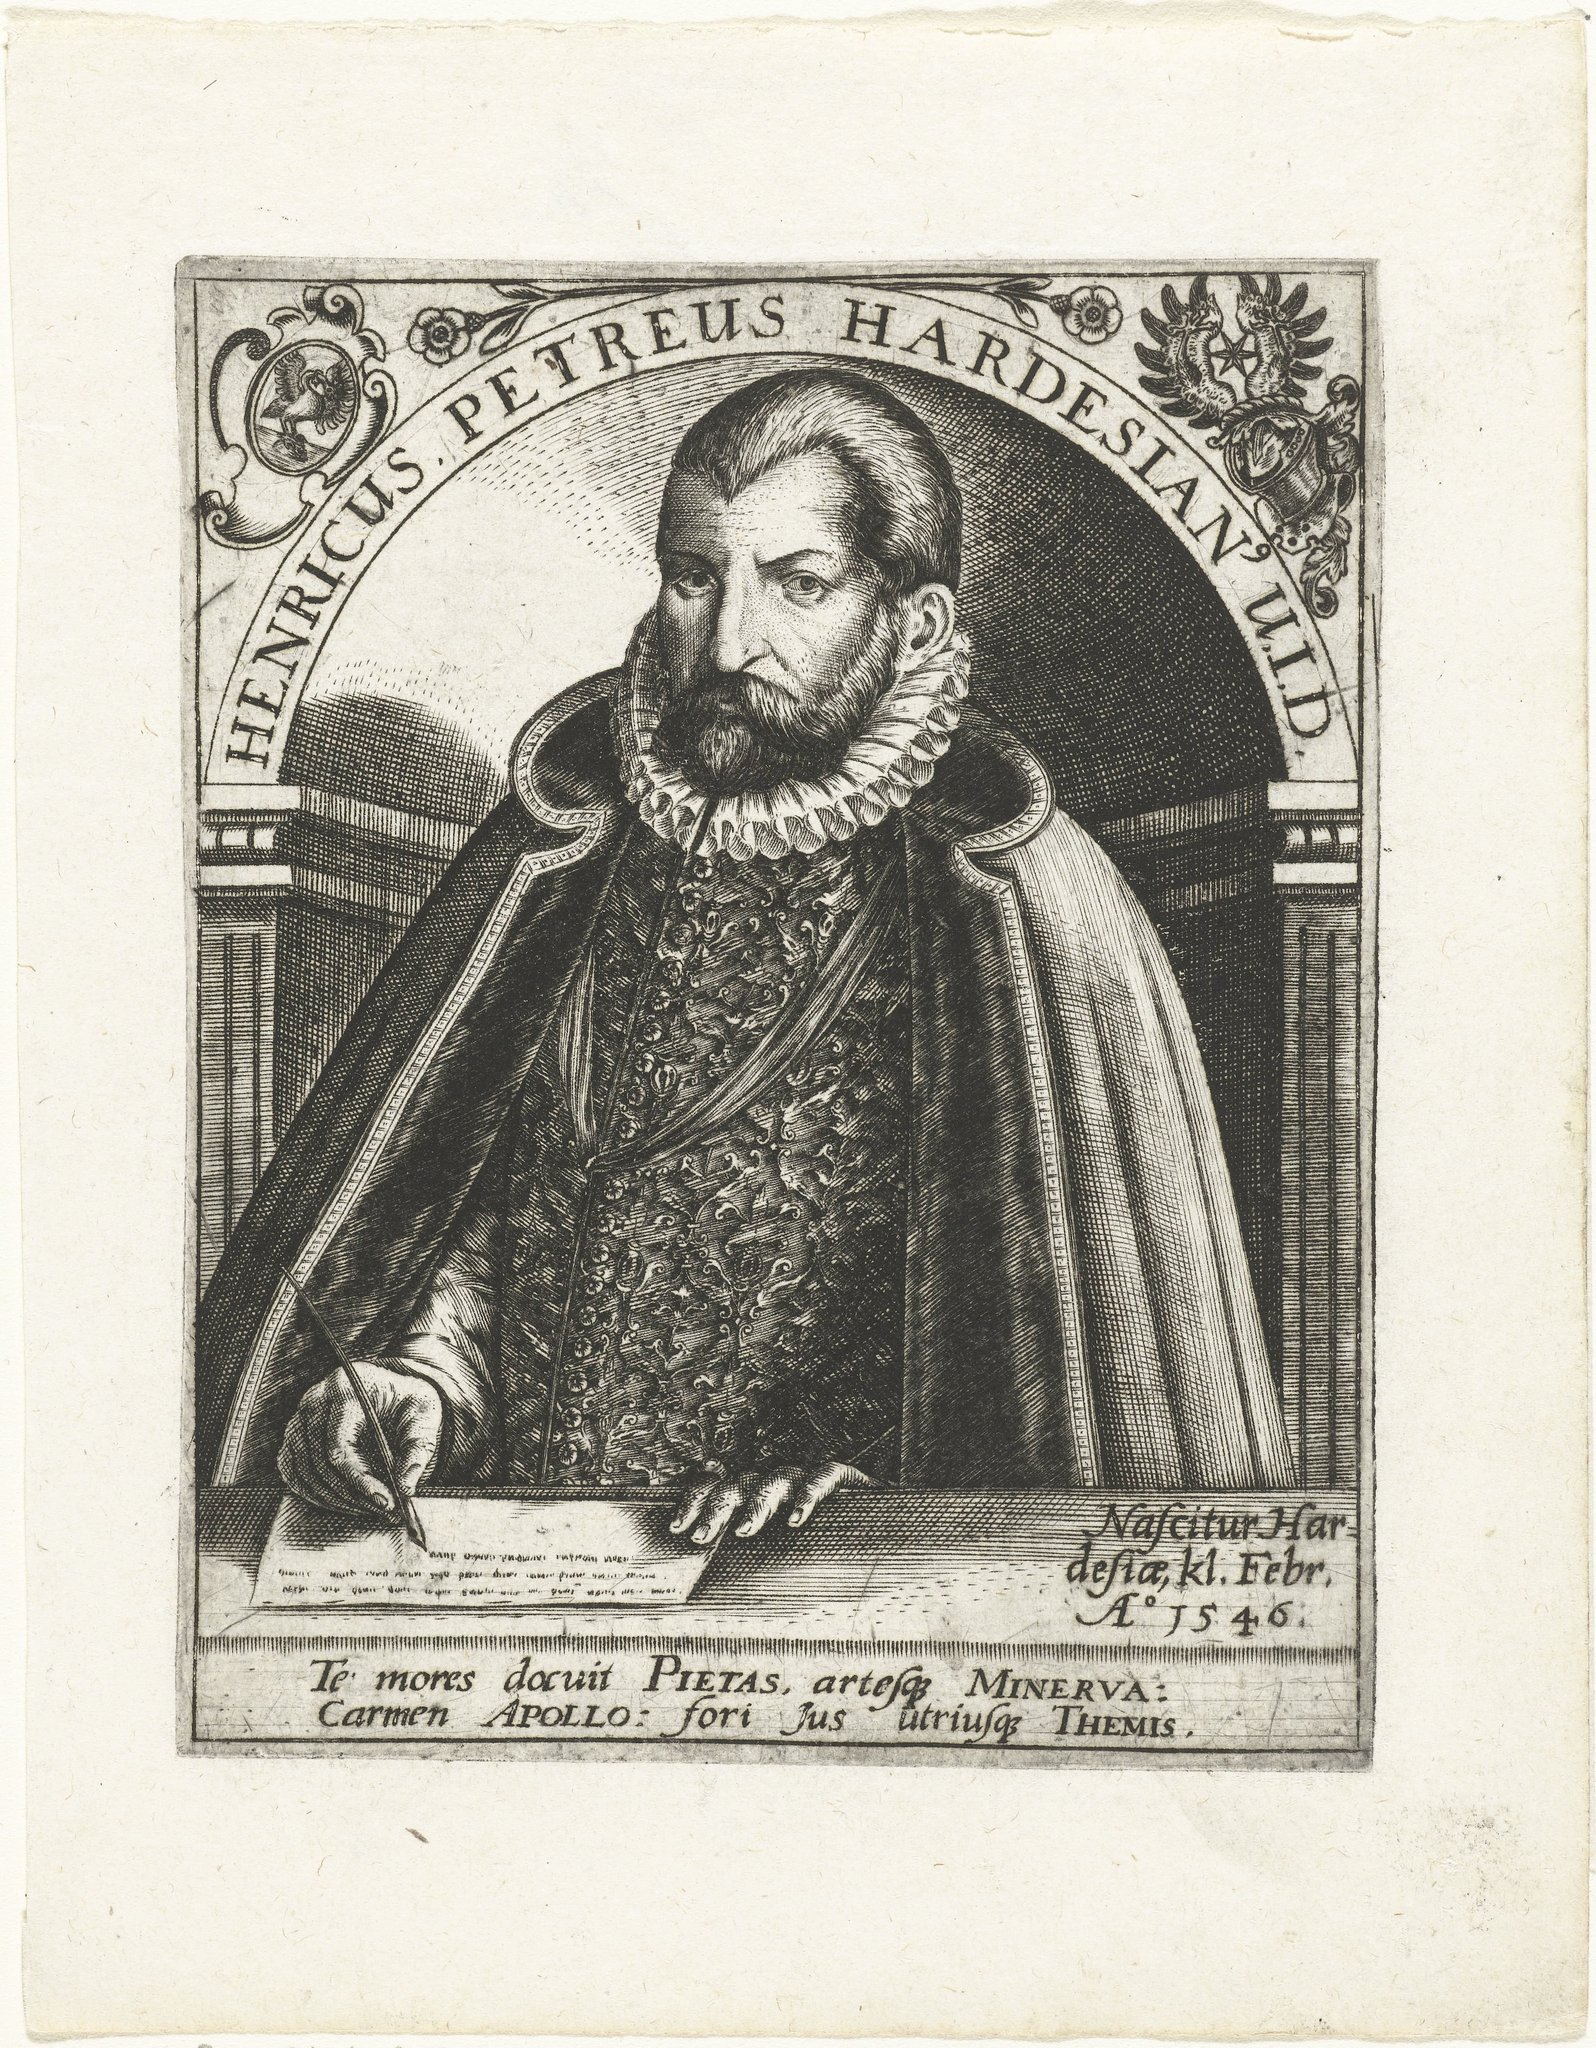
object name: print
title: Portret van Heinrich Petreus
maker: jean jacques boissard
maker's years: 1528-1598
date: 1597-1599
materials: paper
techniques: engraving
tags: schrijver, rechtsgeleerde, heinrich petreus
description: Gemaakt voor: J.J. Boissard, Icones virorum illustrium doctrina &c eruditione praestanti um contines. Frankfurt am Main: de Bry, 1597-1599.